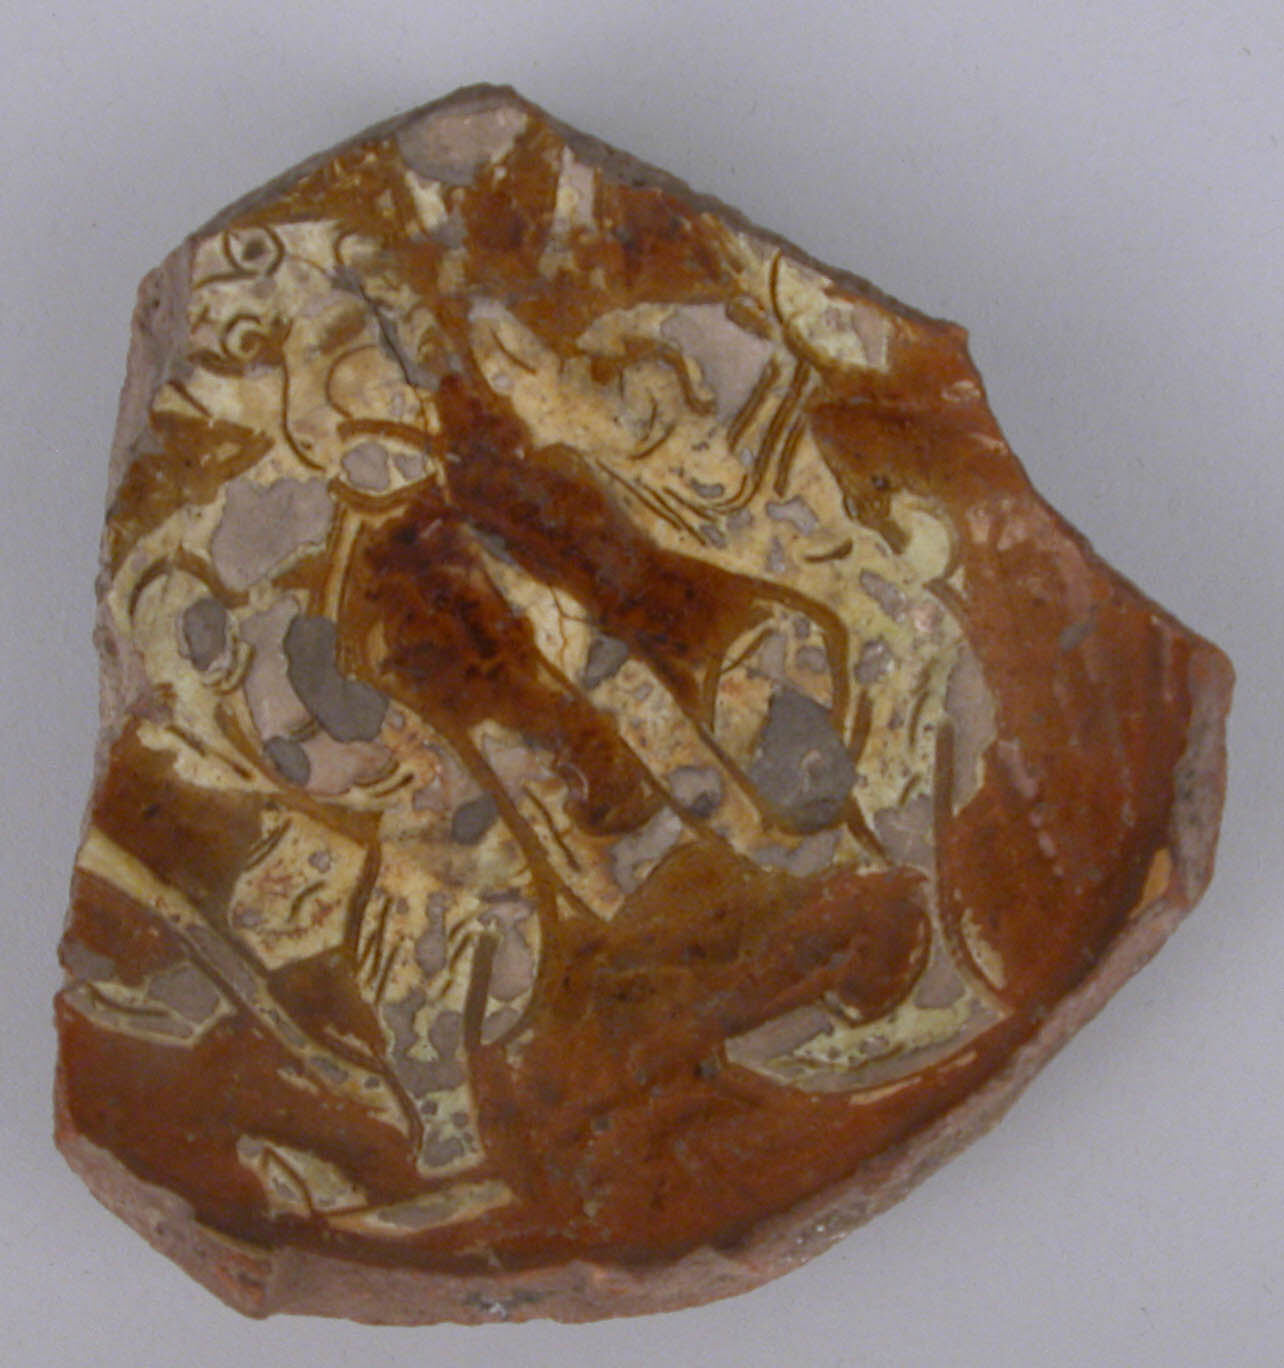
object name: fragment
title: Ceramic Fragment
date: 1301-1400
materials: earthenware, glaze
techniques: coloring, incising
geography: egypt